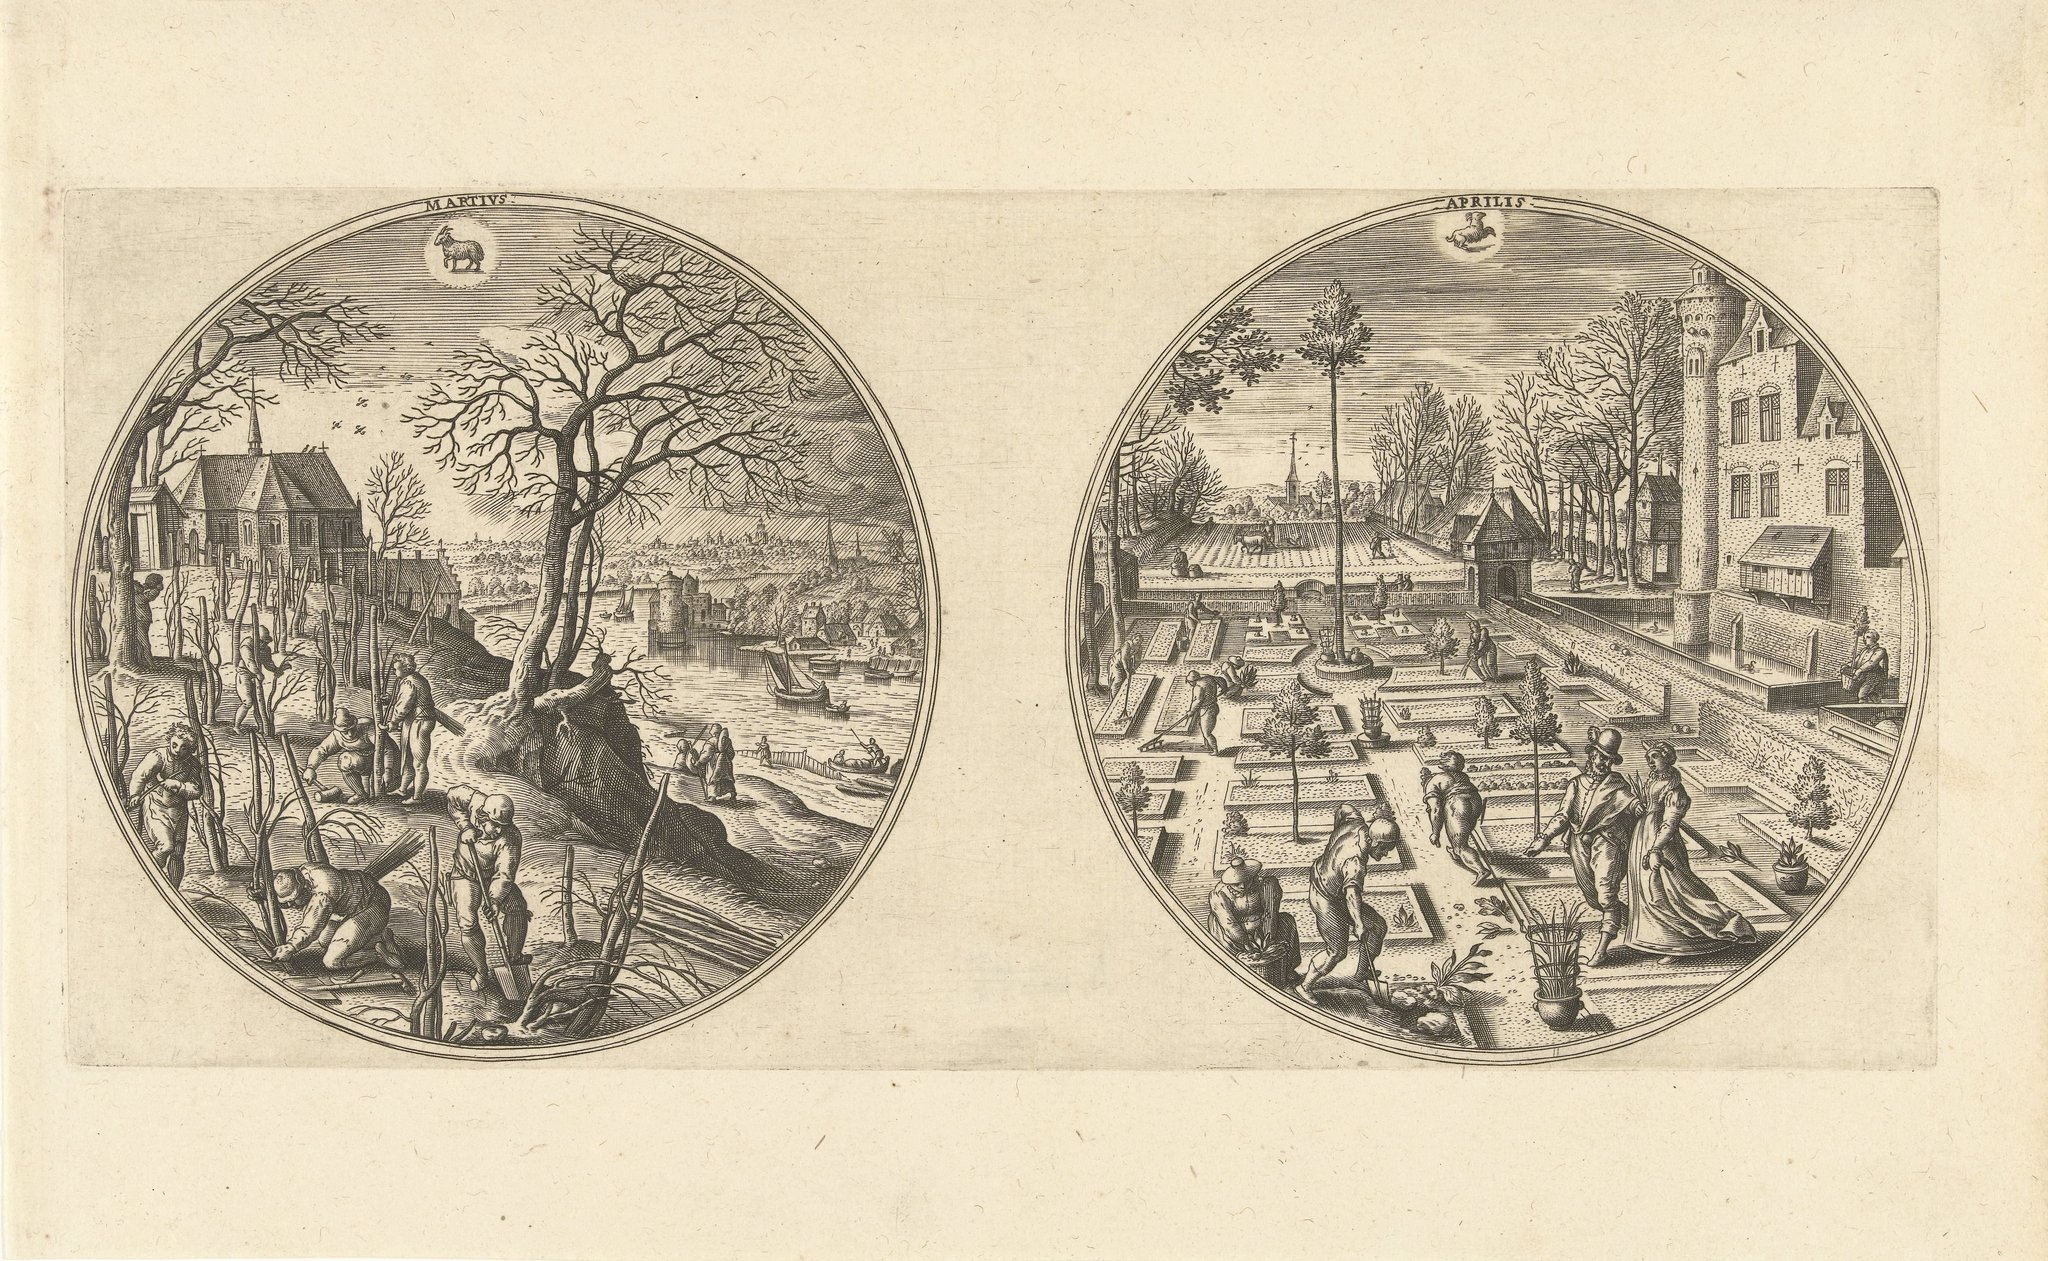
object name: print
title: Maart en april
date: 1578-1582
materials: paper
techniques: engraving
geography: antwerp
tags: sowing, transplanting, setting out plants, march and its 'labours' (+ with zodiacal signs), april and its 'labours' (+ with zodiacal signs), ploughing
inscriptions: collector's mark: Lugt 2228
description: Twee ronde lijsten met landschappen met voorjaarstaferelen. Links maart, de plantmaand. Overal zijn mensen in de weer met het planten van bomen. Middenboven het sterrenbeeld Ram. Rechts april, de grasmaand. Op de voorgrond wordt gespit en gezaaid in de tuin. Op de achtergrond wordt een veld omgeploegd. Middenboven het sterrenbeeld Stier. De prent is deel van een serie over de twaalf maanden.